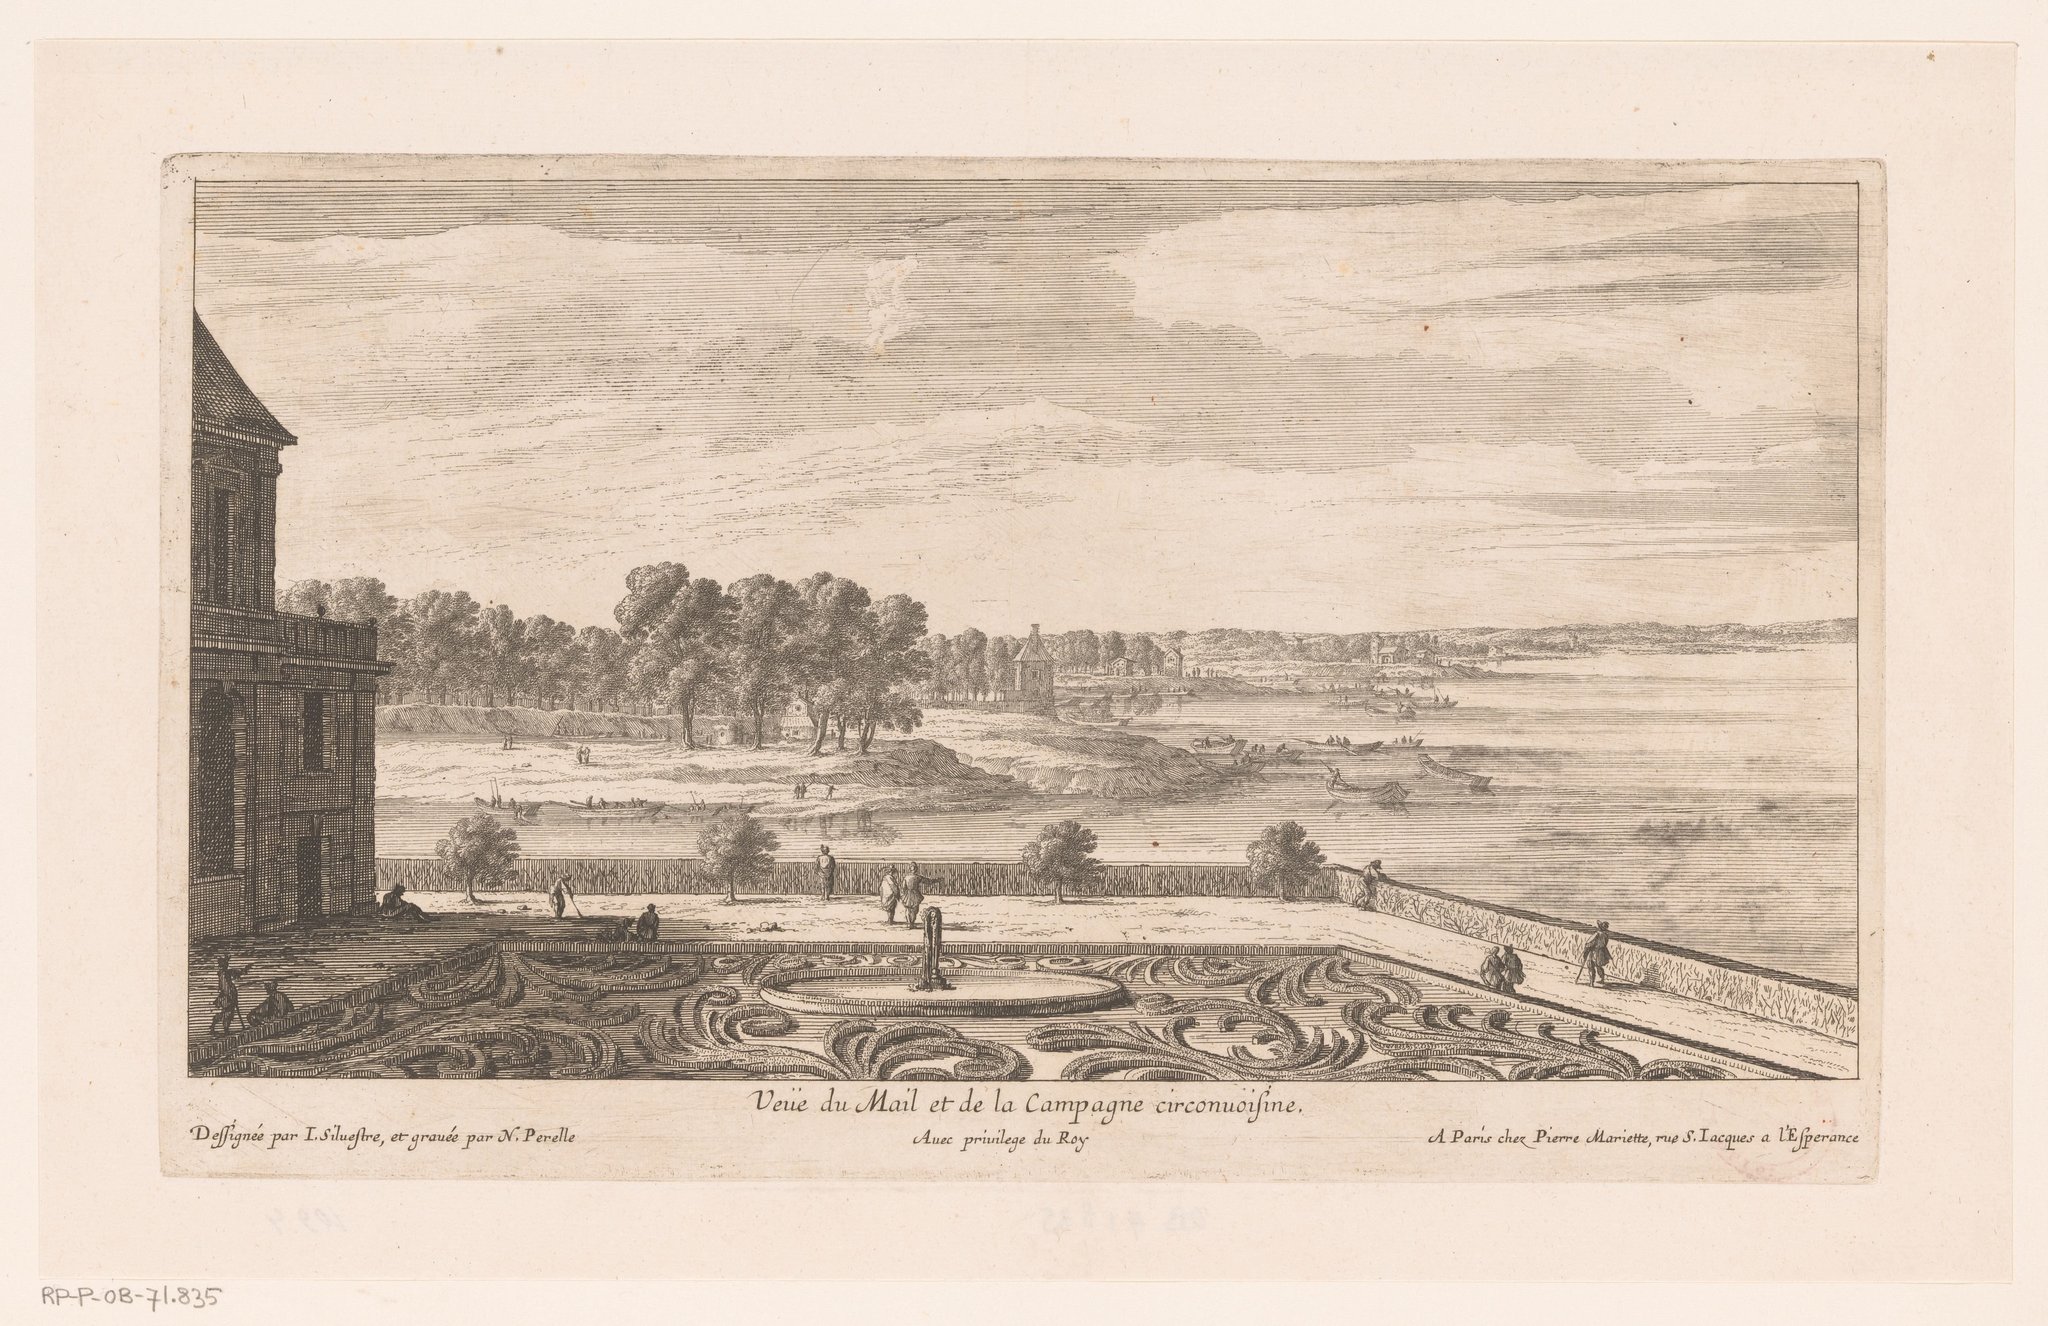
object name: print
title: Veue du Mail et de la Campagne circonvoisine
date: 1641-1695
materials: paper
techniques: engraving, etching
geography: france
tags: landscapes, french or architectonic garden; formal garden